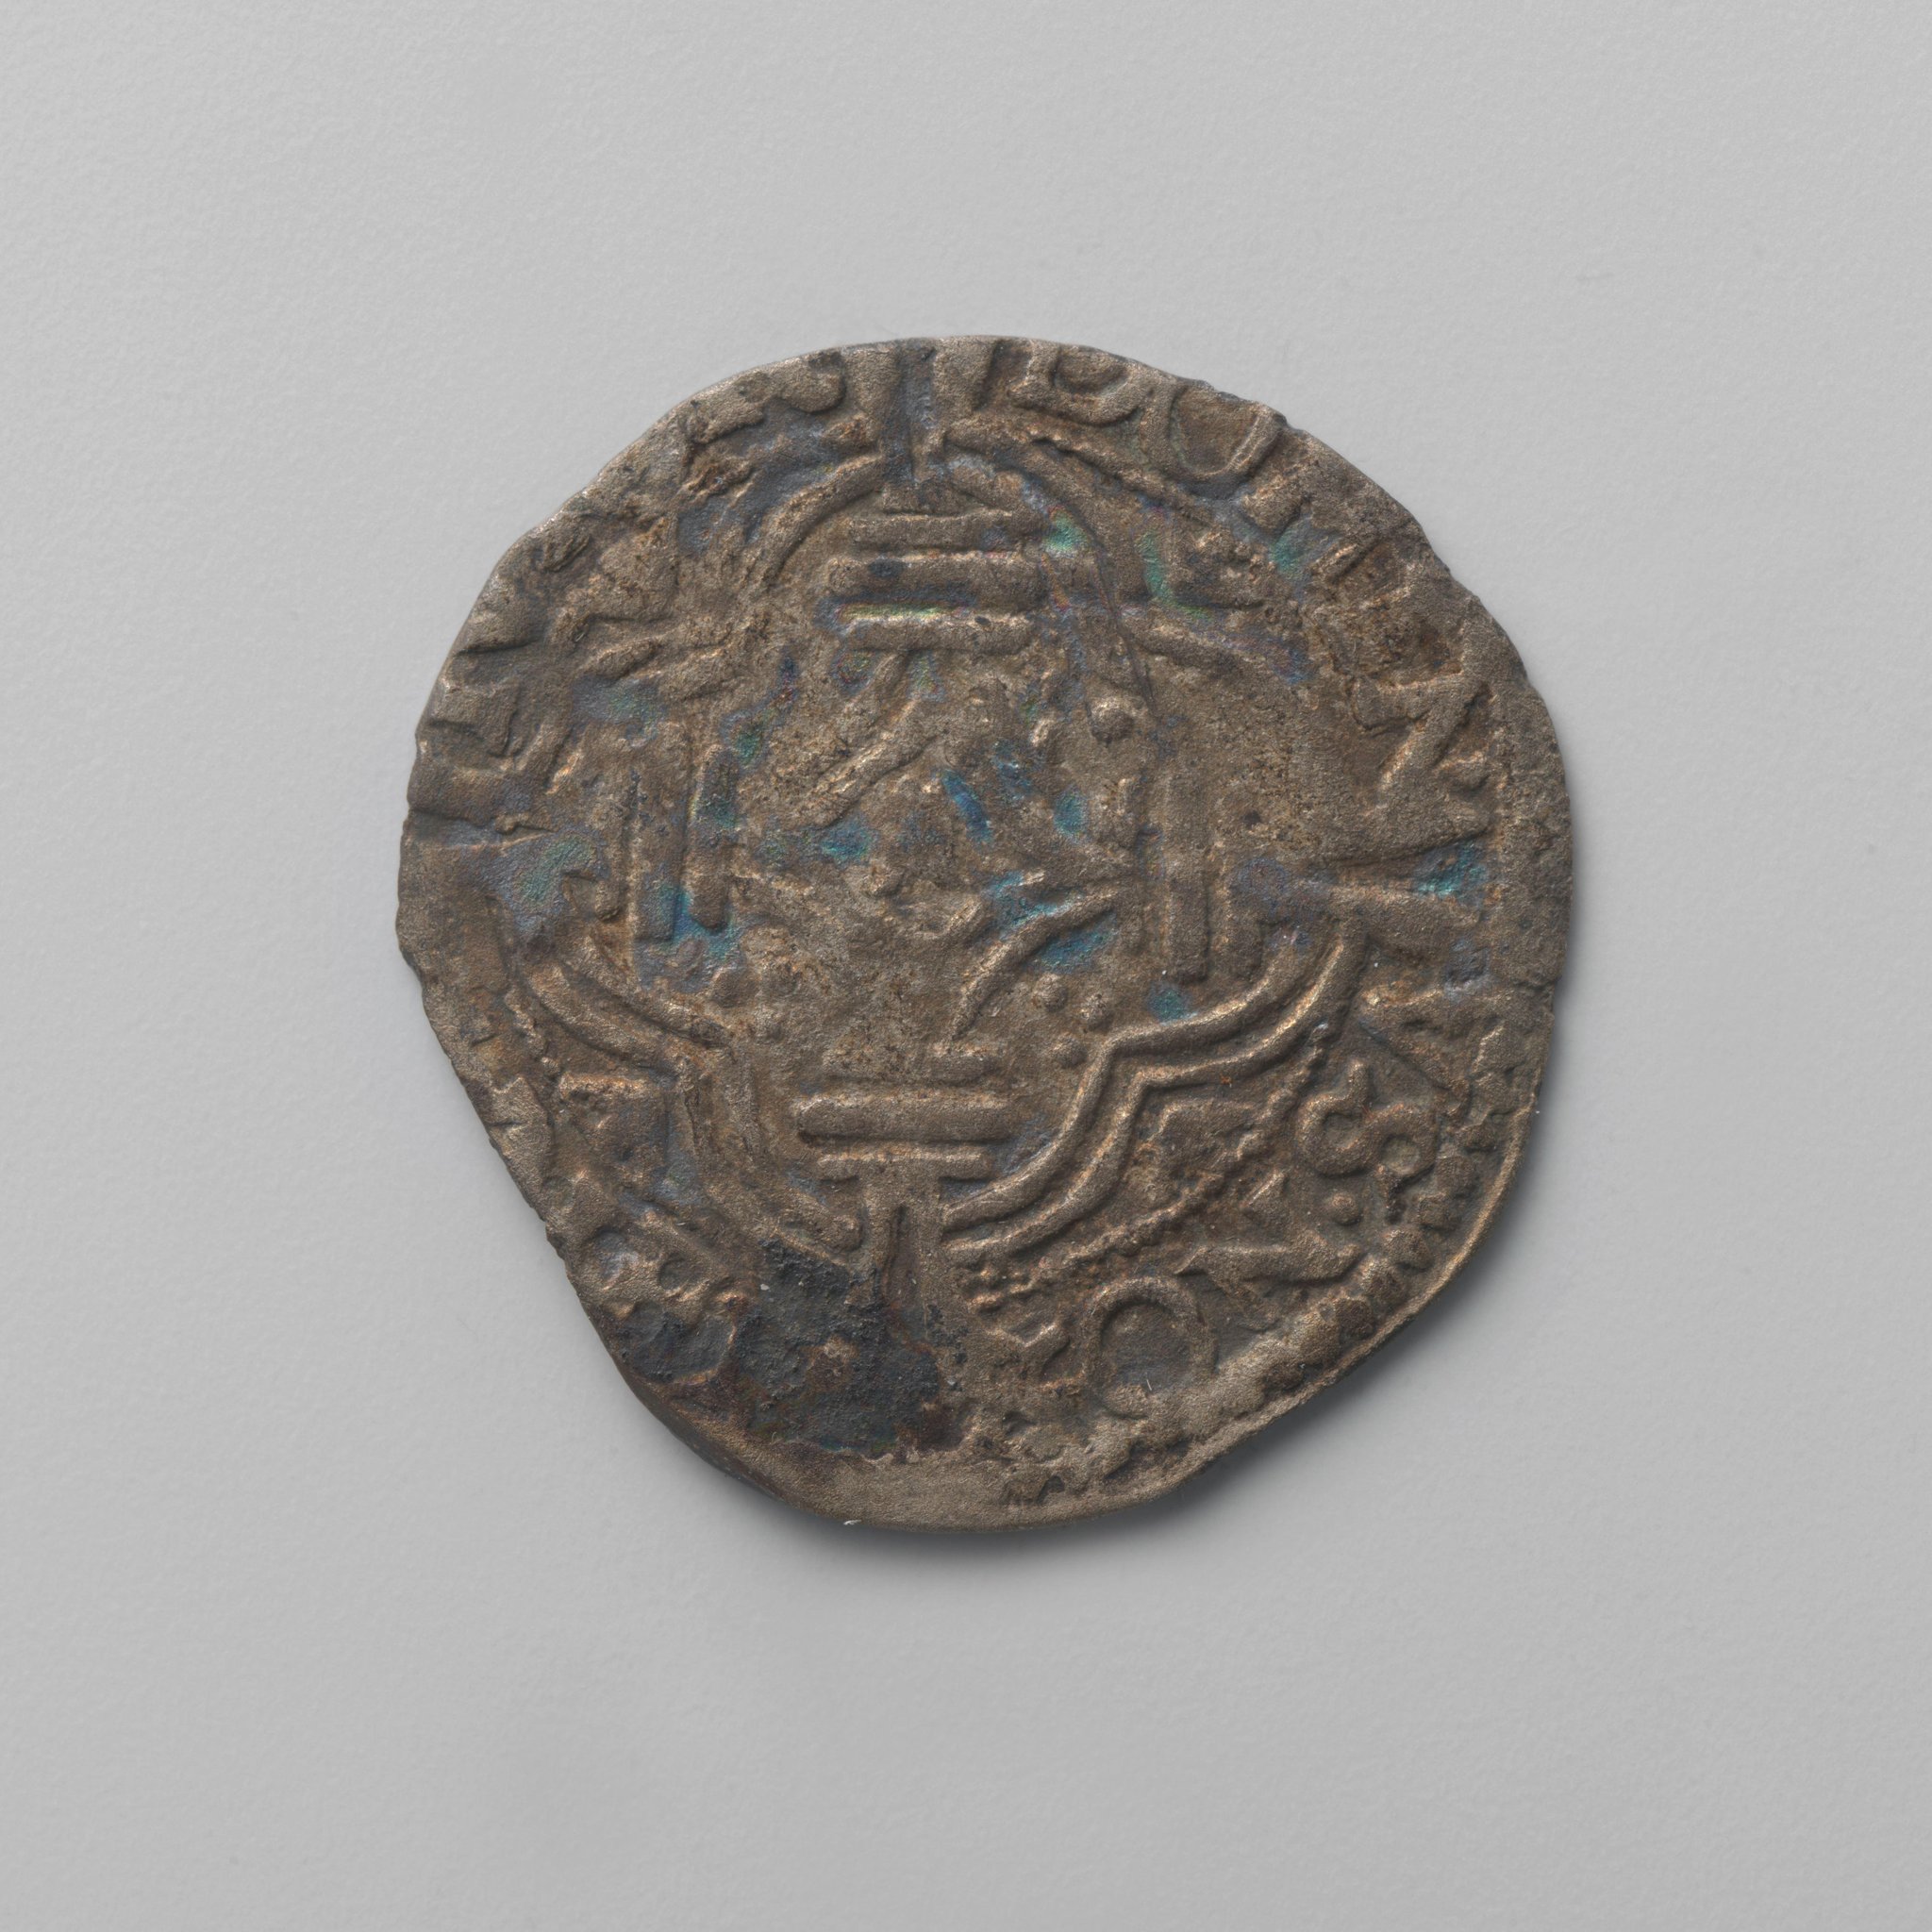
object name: coin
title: Kampen, stuiver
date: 1590-1610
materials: silver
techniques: striking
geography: kampen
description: Zilveren munt. Voorzijde: tussen waarde-aanduiding I S gekroond vereenvoudigd Spaans wapenschild. Keerzijde: op dubbellijnige vierpas lang gevoet kruis met in het centrum een kleine rooos. In de hoeken drie bolletjes.